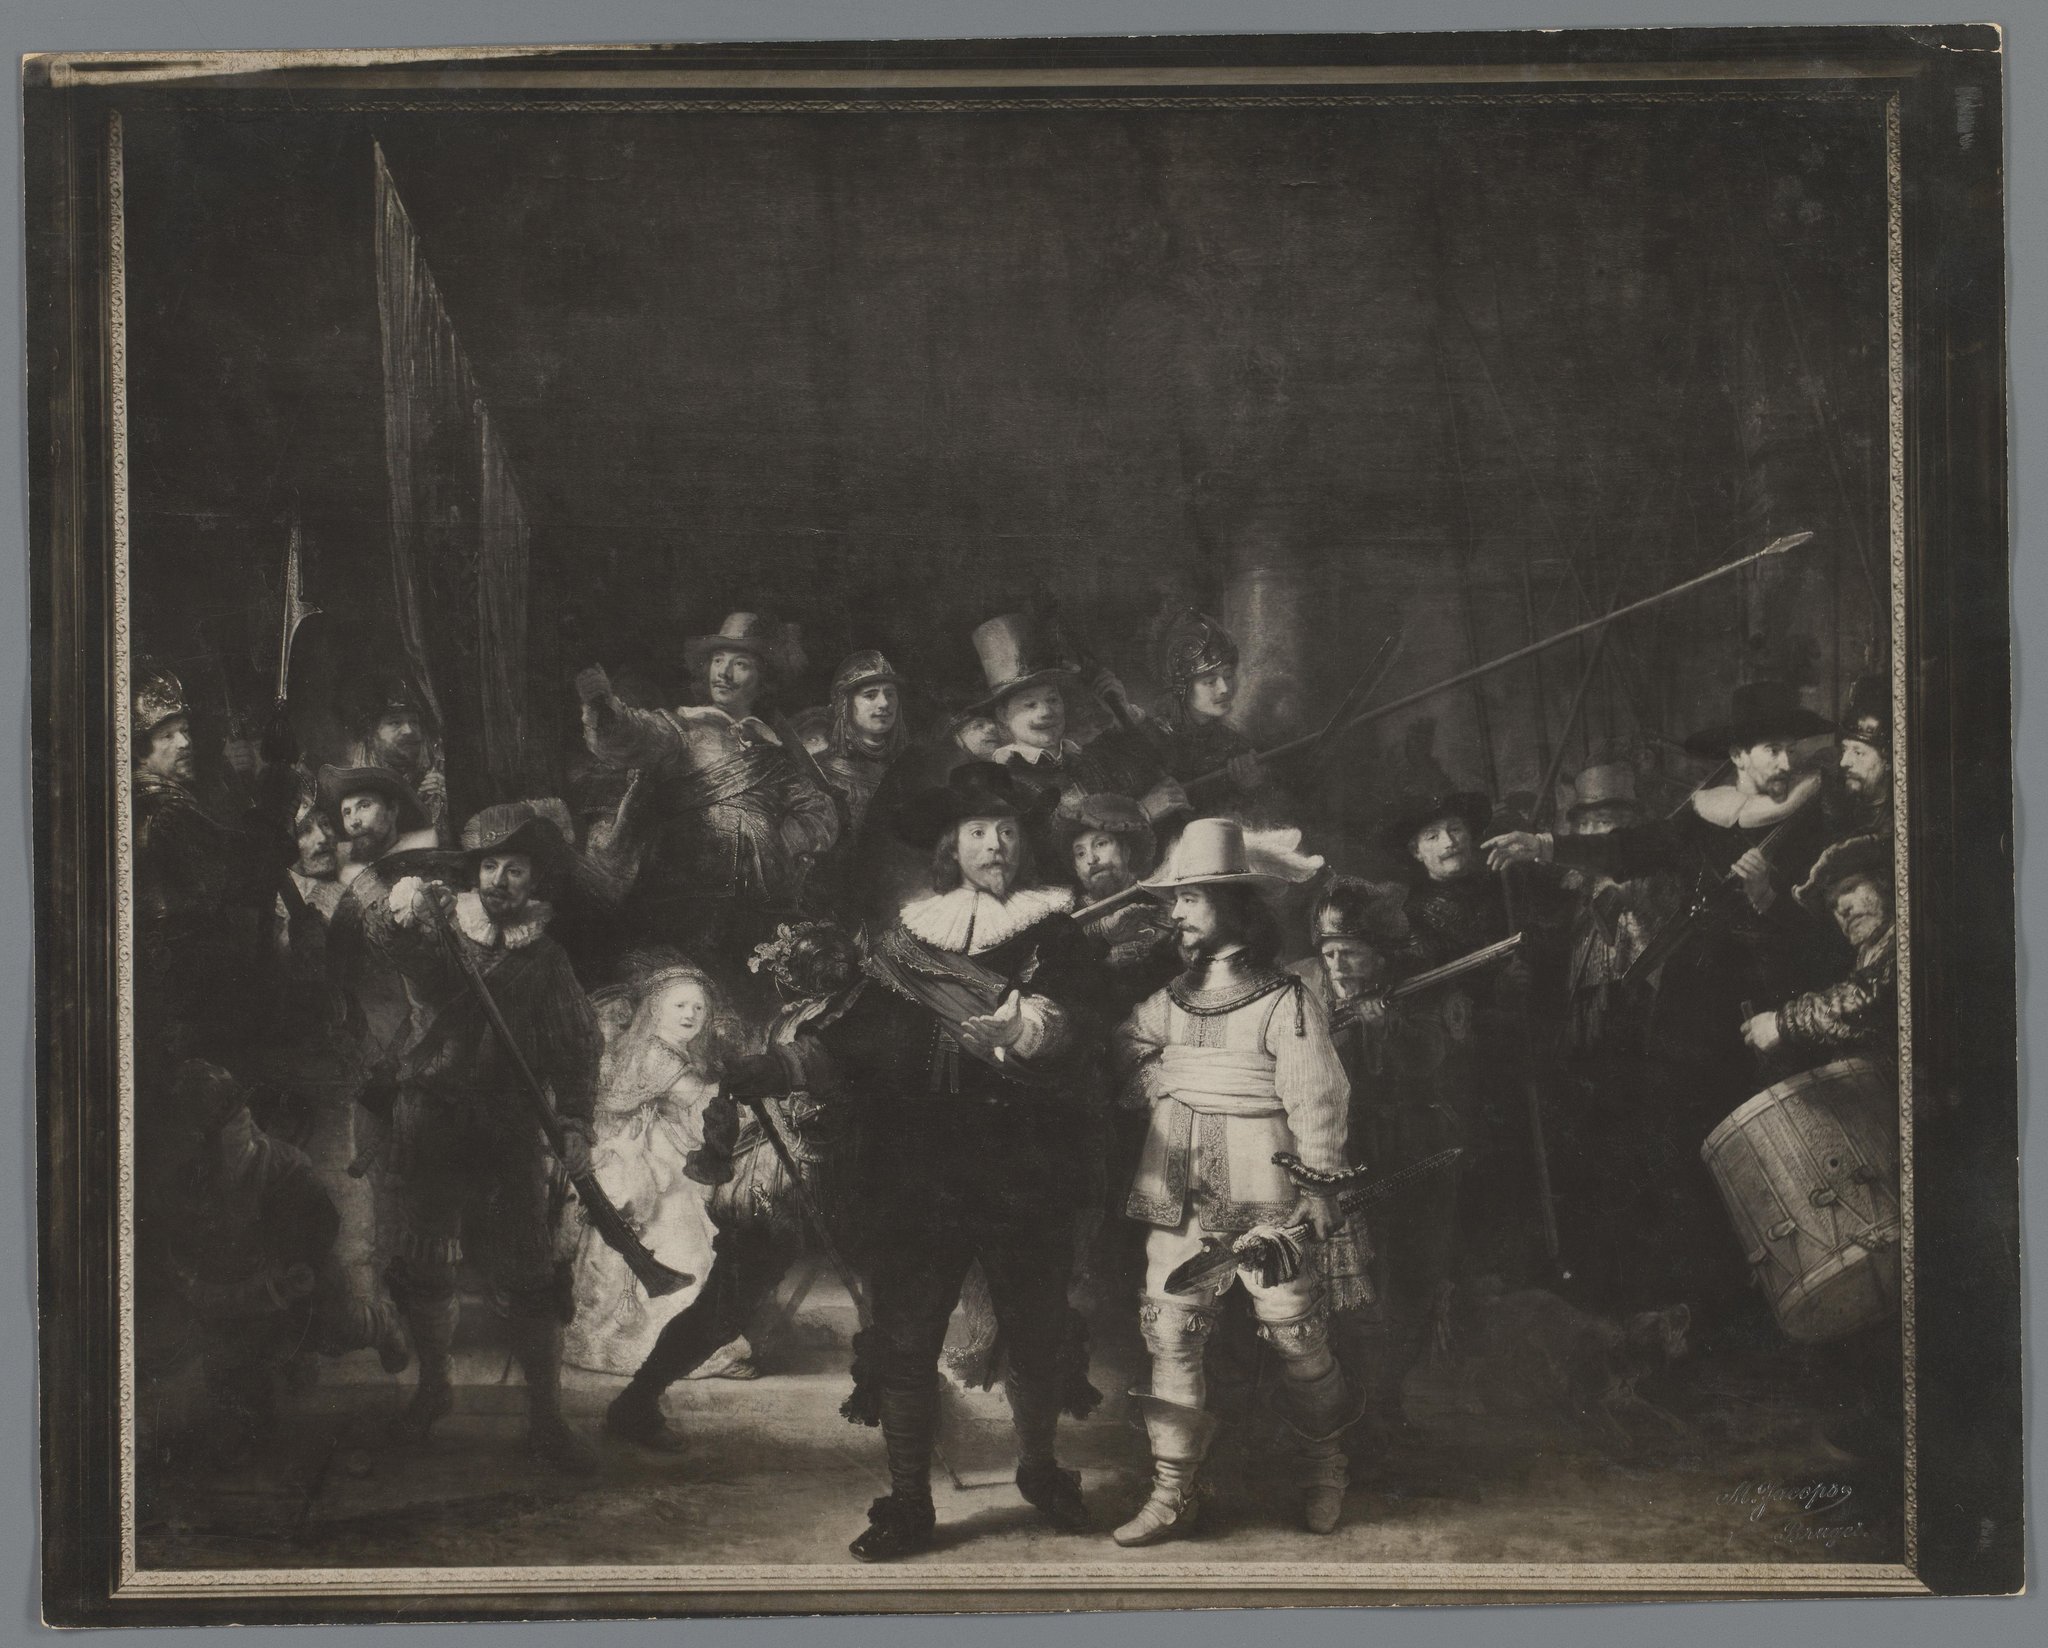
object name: photograph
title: Fotoreproductie van het schilderij De Nachtwacht van Rembrandt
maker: max jacops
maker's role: publisher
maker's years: 1879-1947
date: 1903-1911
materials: paper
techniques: gelatin silver print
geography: amsterdam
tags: mayor, frans banninck cocq, night patrol, (military) standard-bearer, amsterdam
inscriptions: inscription: ‘Max Jacops/ Brugge’, inscription: ‘M. Jacops/ Bruges.’